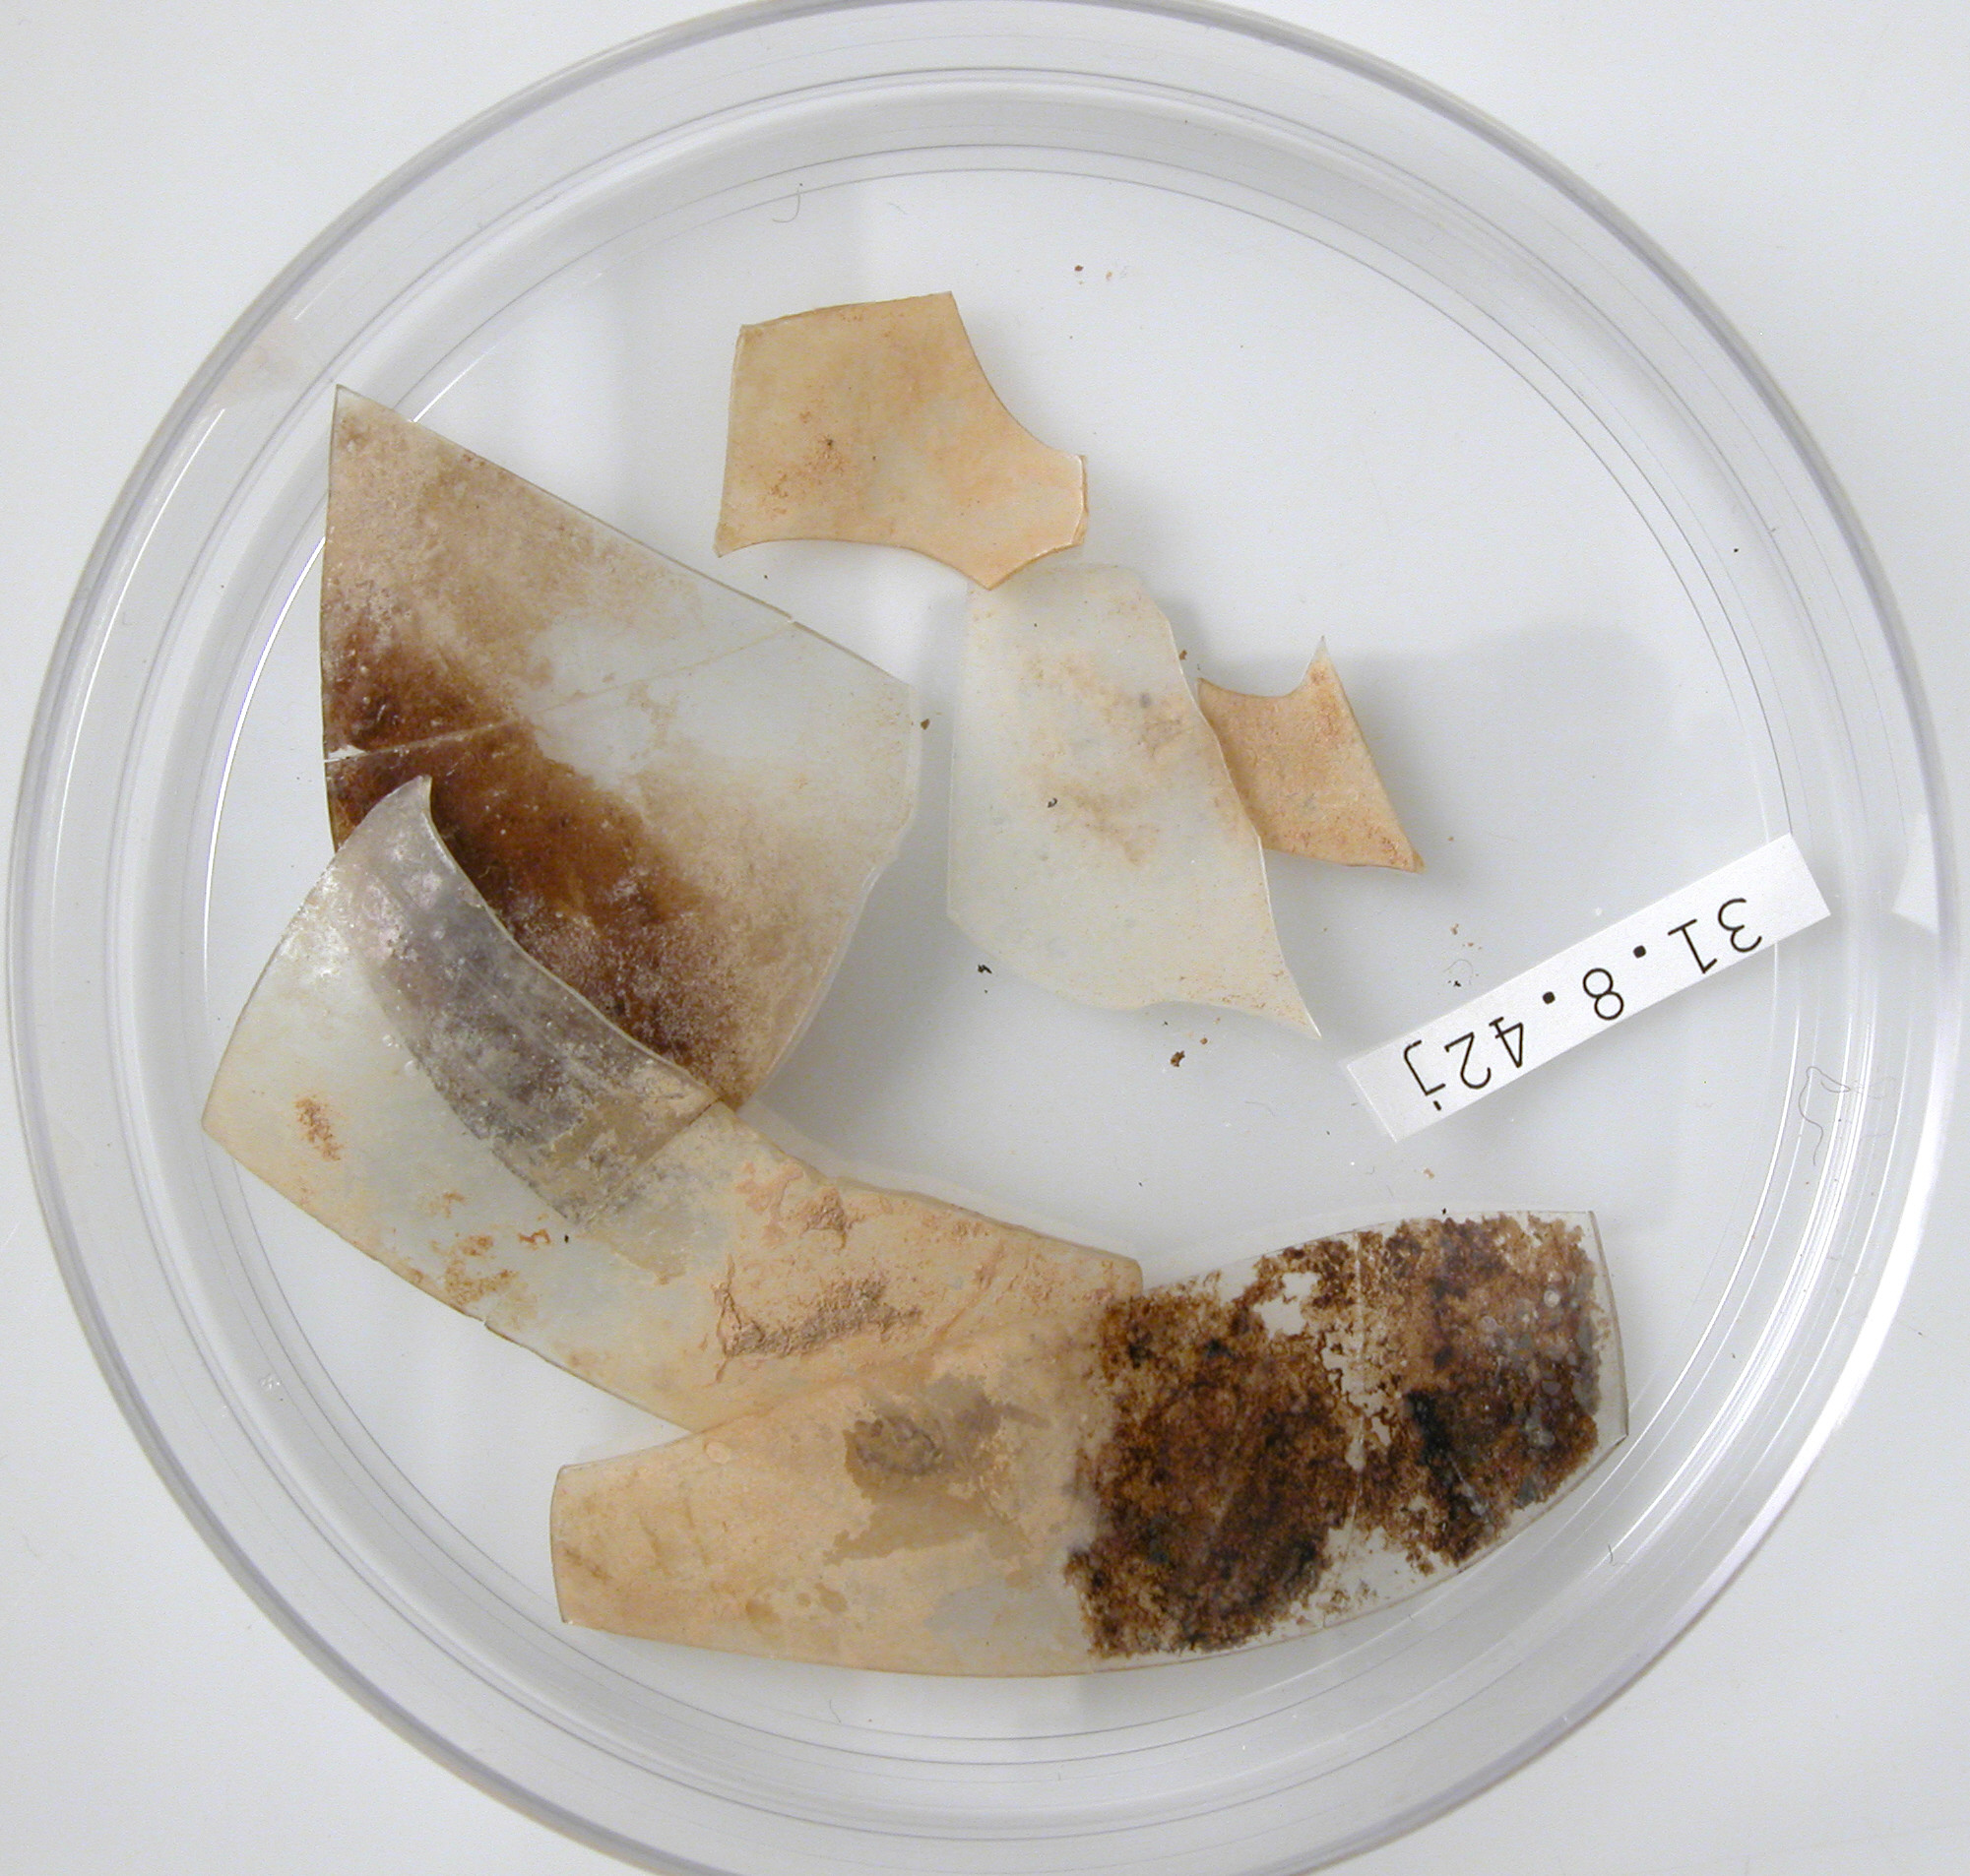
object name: fragment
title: Glass Fragments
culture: coptic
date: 301-400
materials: glass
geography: egypt